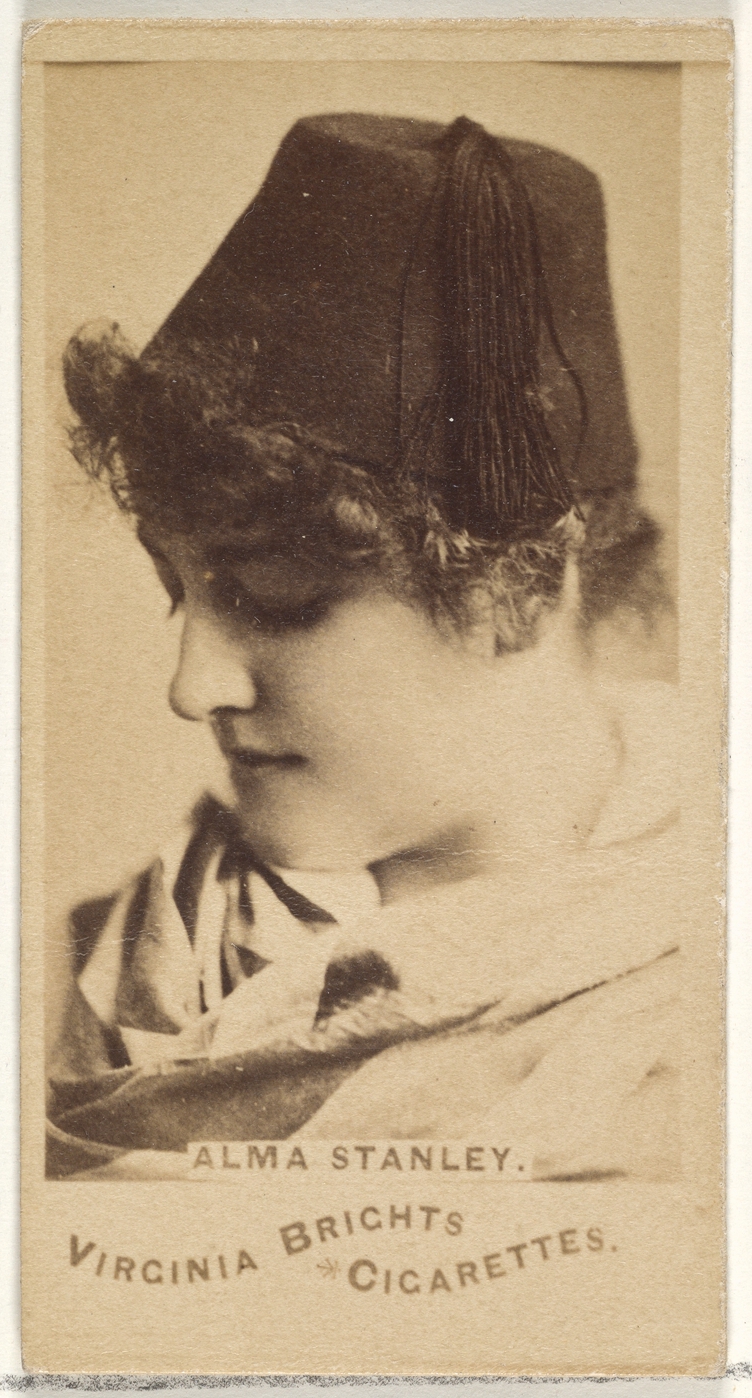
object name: photograph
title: Alma Stanley, from the Actors and Actresses series (N45, Type 1) for Virginia Brights Cigarettes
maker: allen & ginter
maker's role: publisher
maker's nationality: american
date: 1888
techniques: albumen silver print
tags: women,actresses